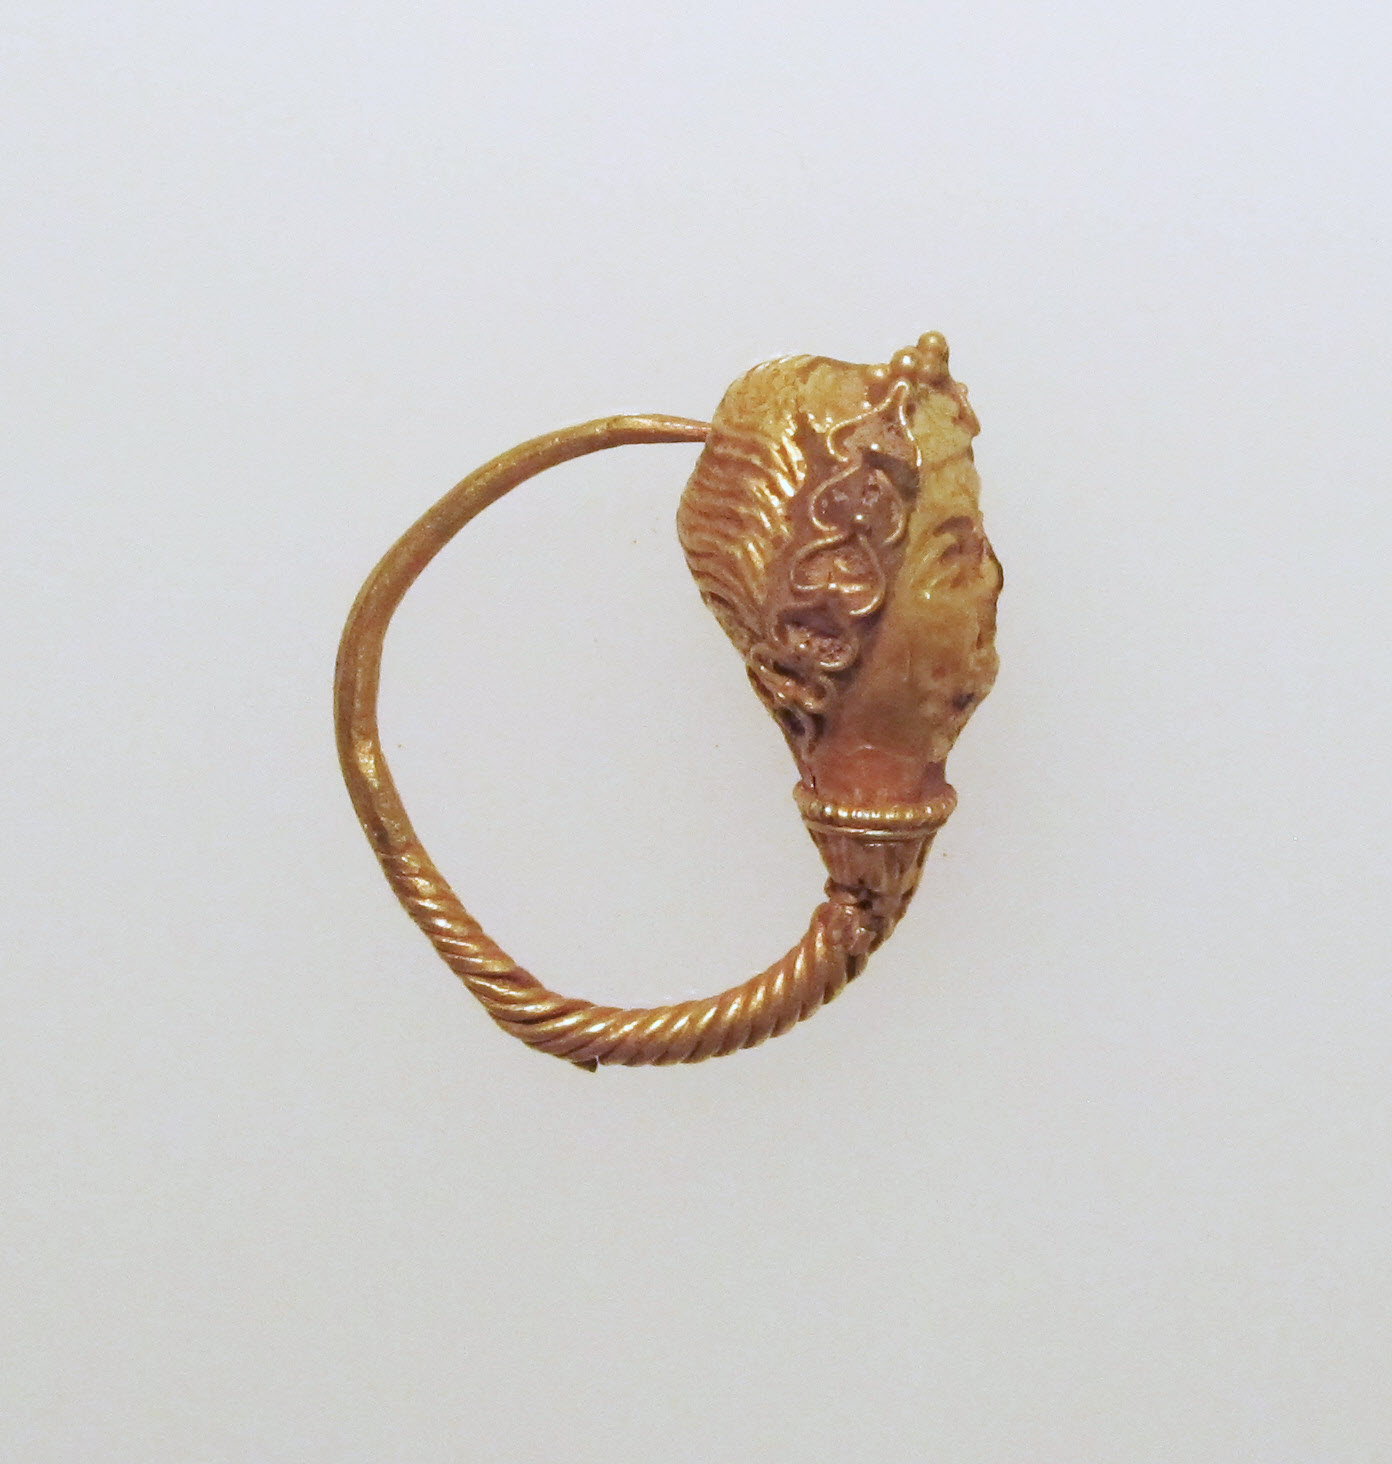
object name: earring with human head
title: Gold earring with woman's head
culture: greek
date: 300-101 BCE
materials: gold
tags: heads,women